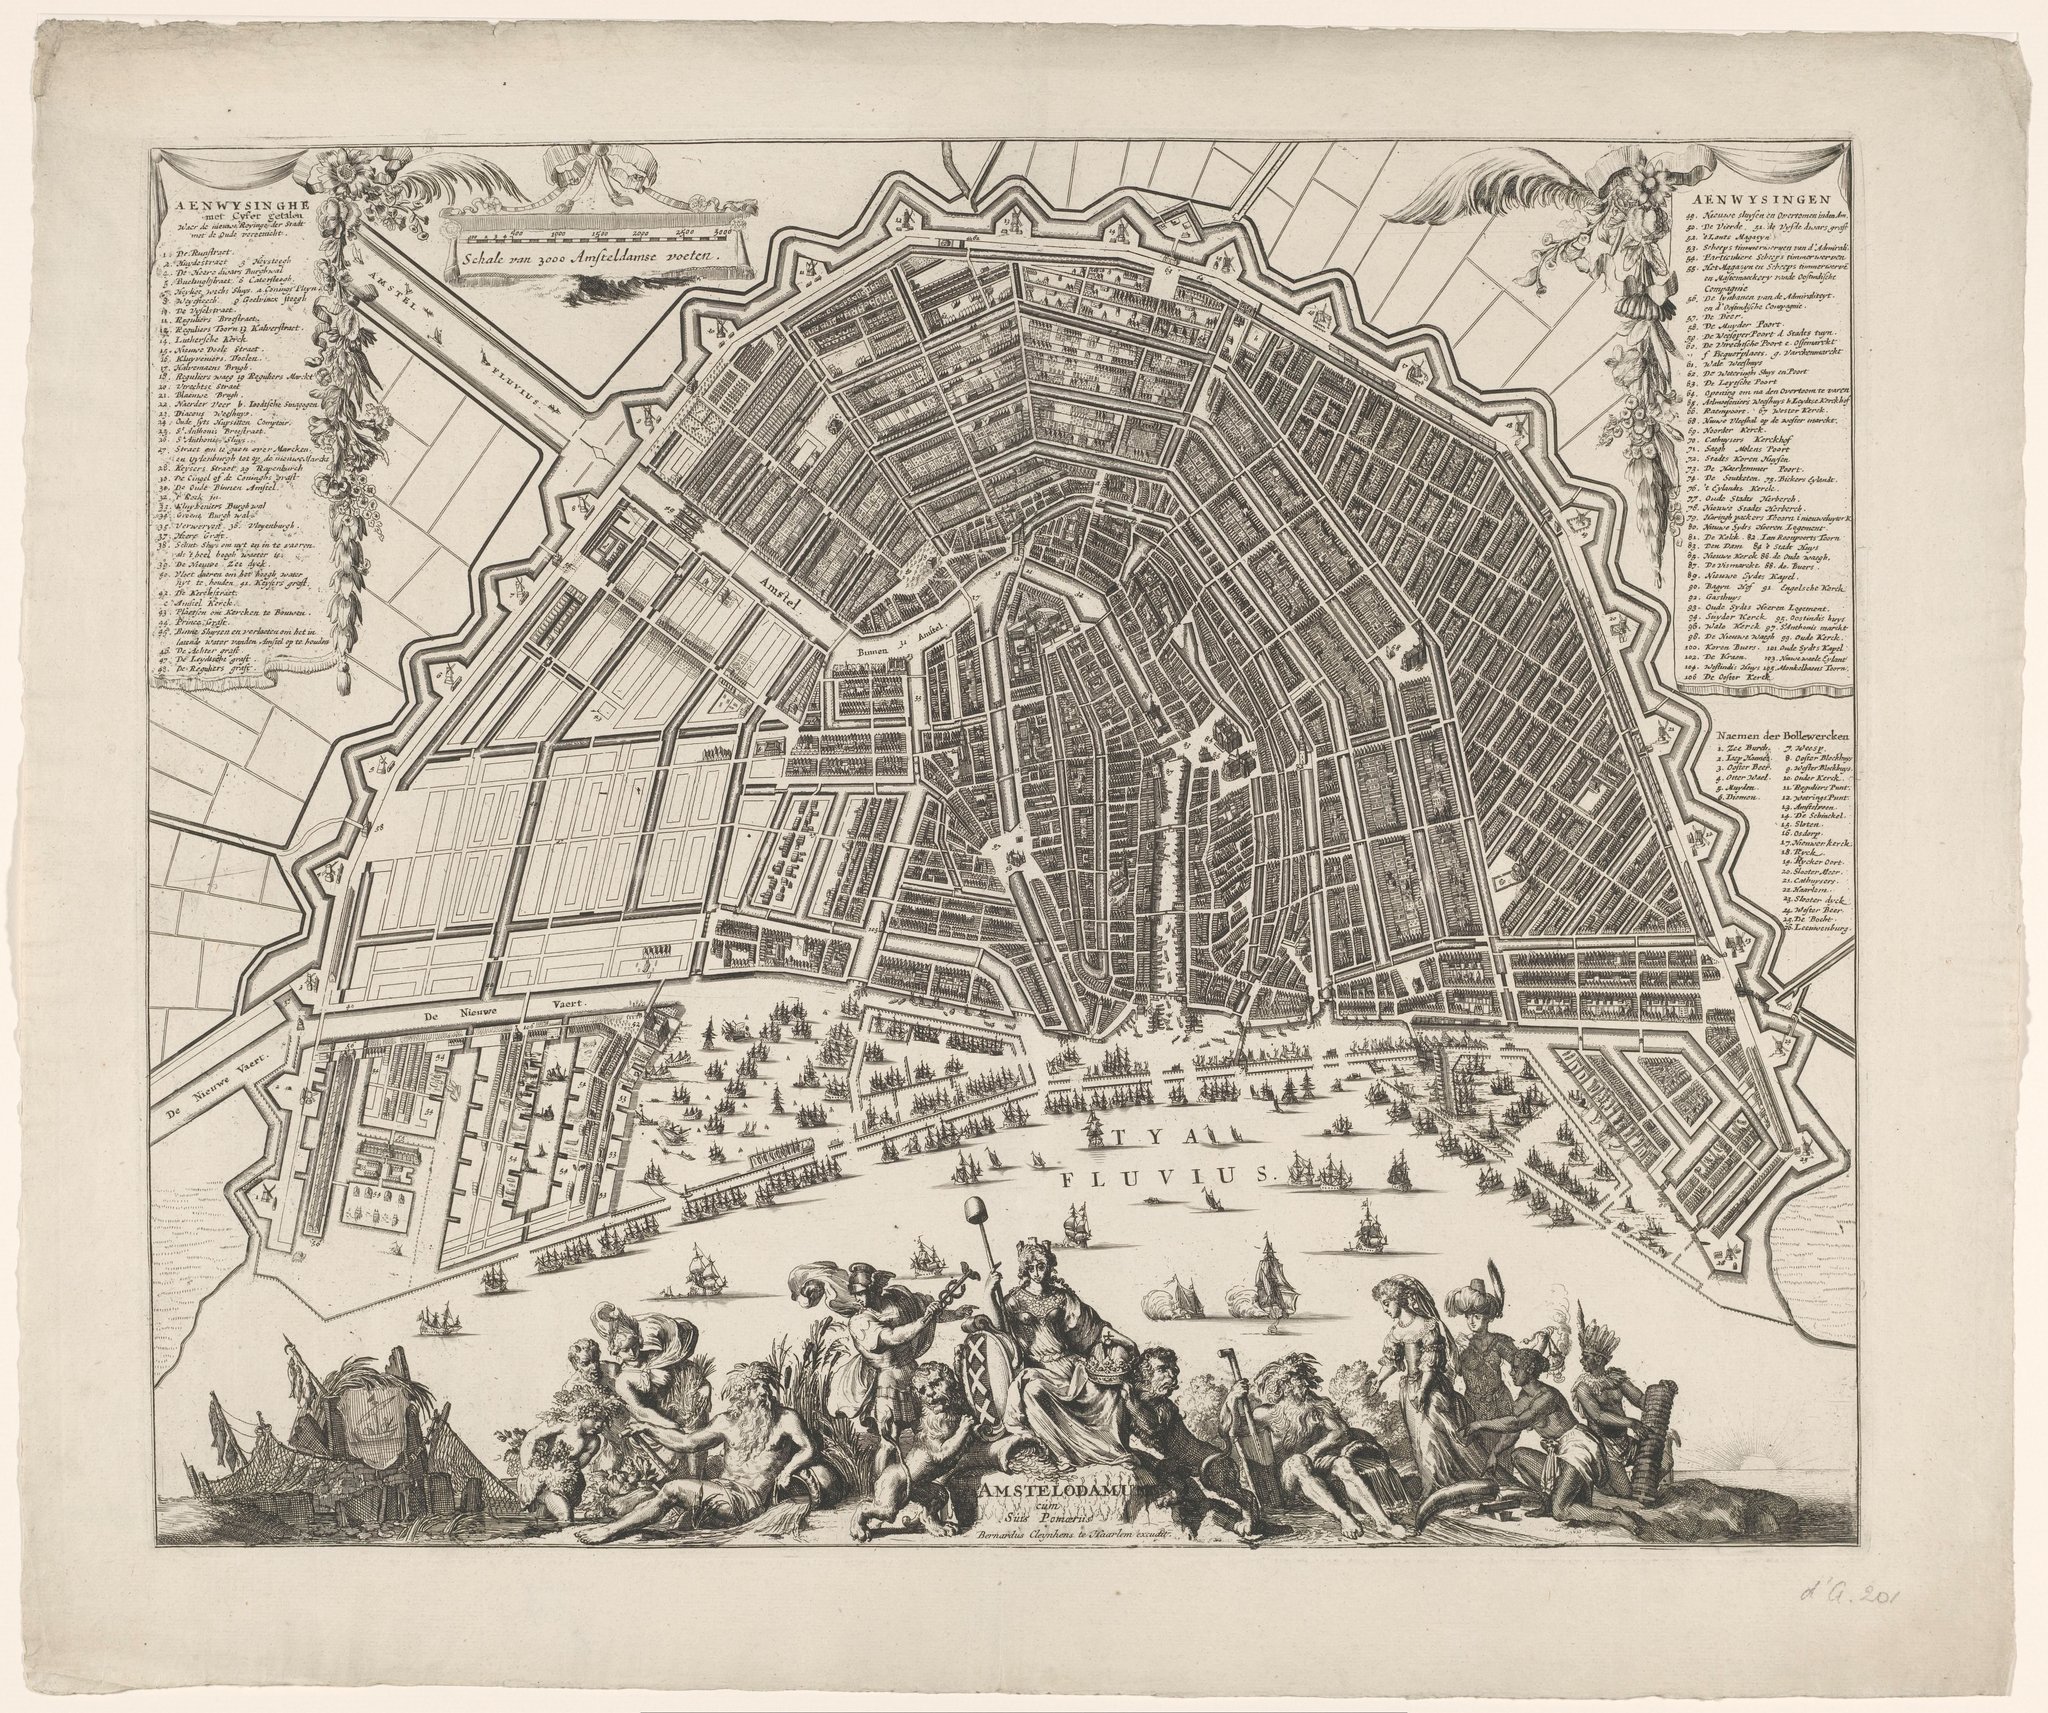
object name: area plan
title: Plattegrond van Amsterdam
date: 1674-1682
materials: paper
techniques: engraving, etching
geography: amsterdam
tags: commercial fishery, (story of) ceres (demeter), coat of arms (as symbol of the state, etc.) (+ city; municipal), (story of) bacchus (dionysus), liber, europe represented allegorically; 'europa' (ripa), river personified, 'fiumi' (ripa) - hh - ideal landscapes, fishing net, seal (as symbol of the state, etc.) (+ city; municipal), asia represented allegorically; 'asia' (ripa), africa represented allegorically; 'africa' (ripa), (story of) mercury (hermes), america represented allegorically; 'america' (ripa), river-gods, maps of cities, continents represented allegorically, faunus, amsterdam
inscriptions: collector's mark: Lugt 2228